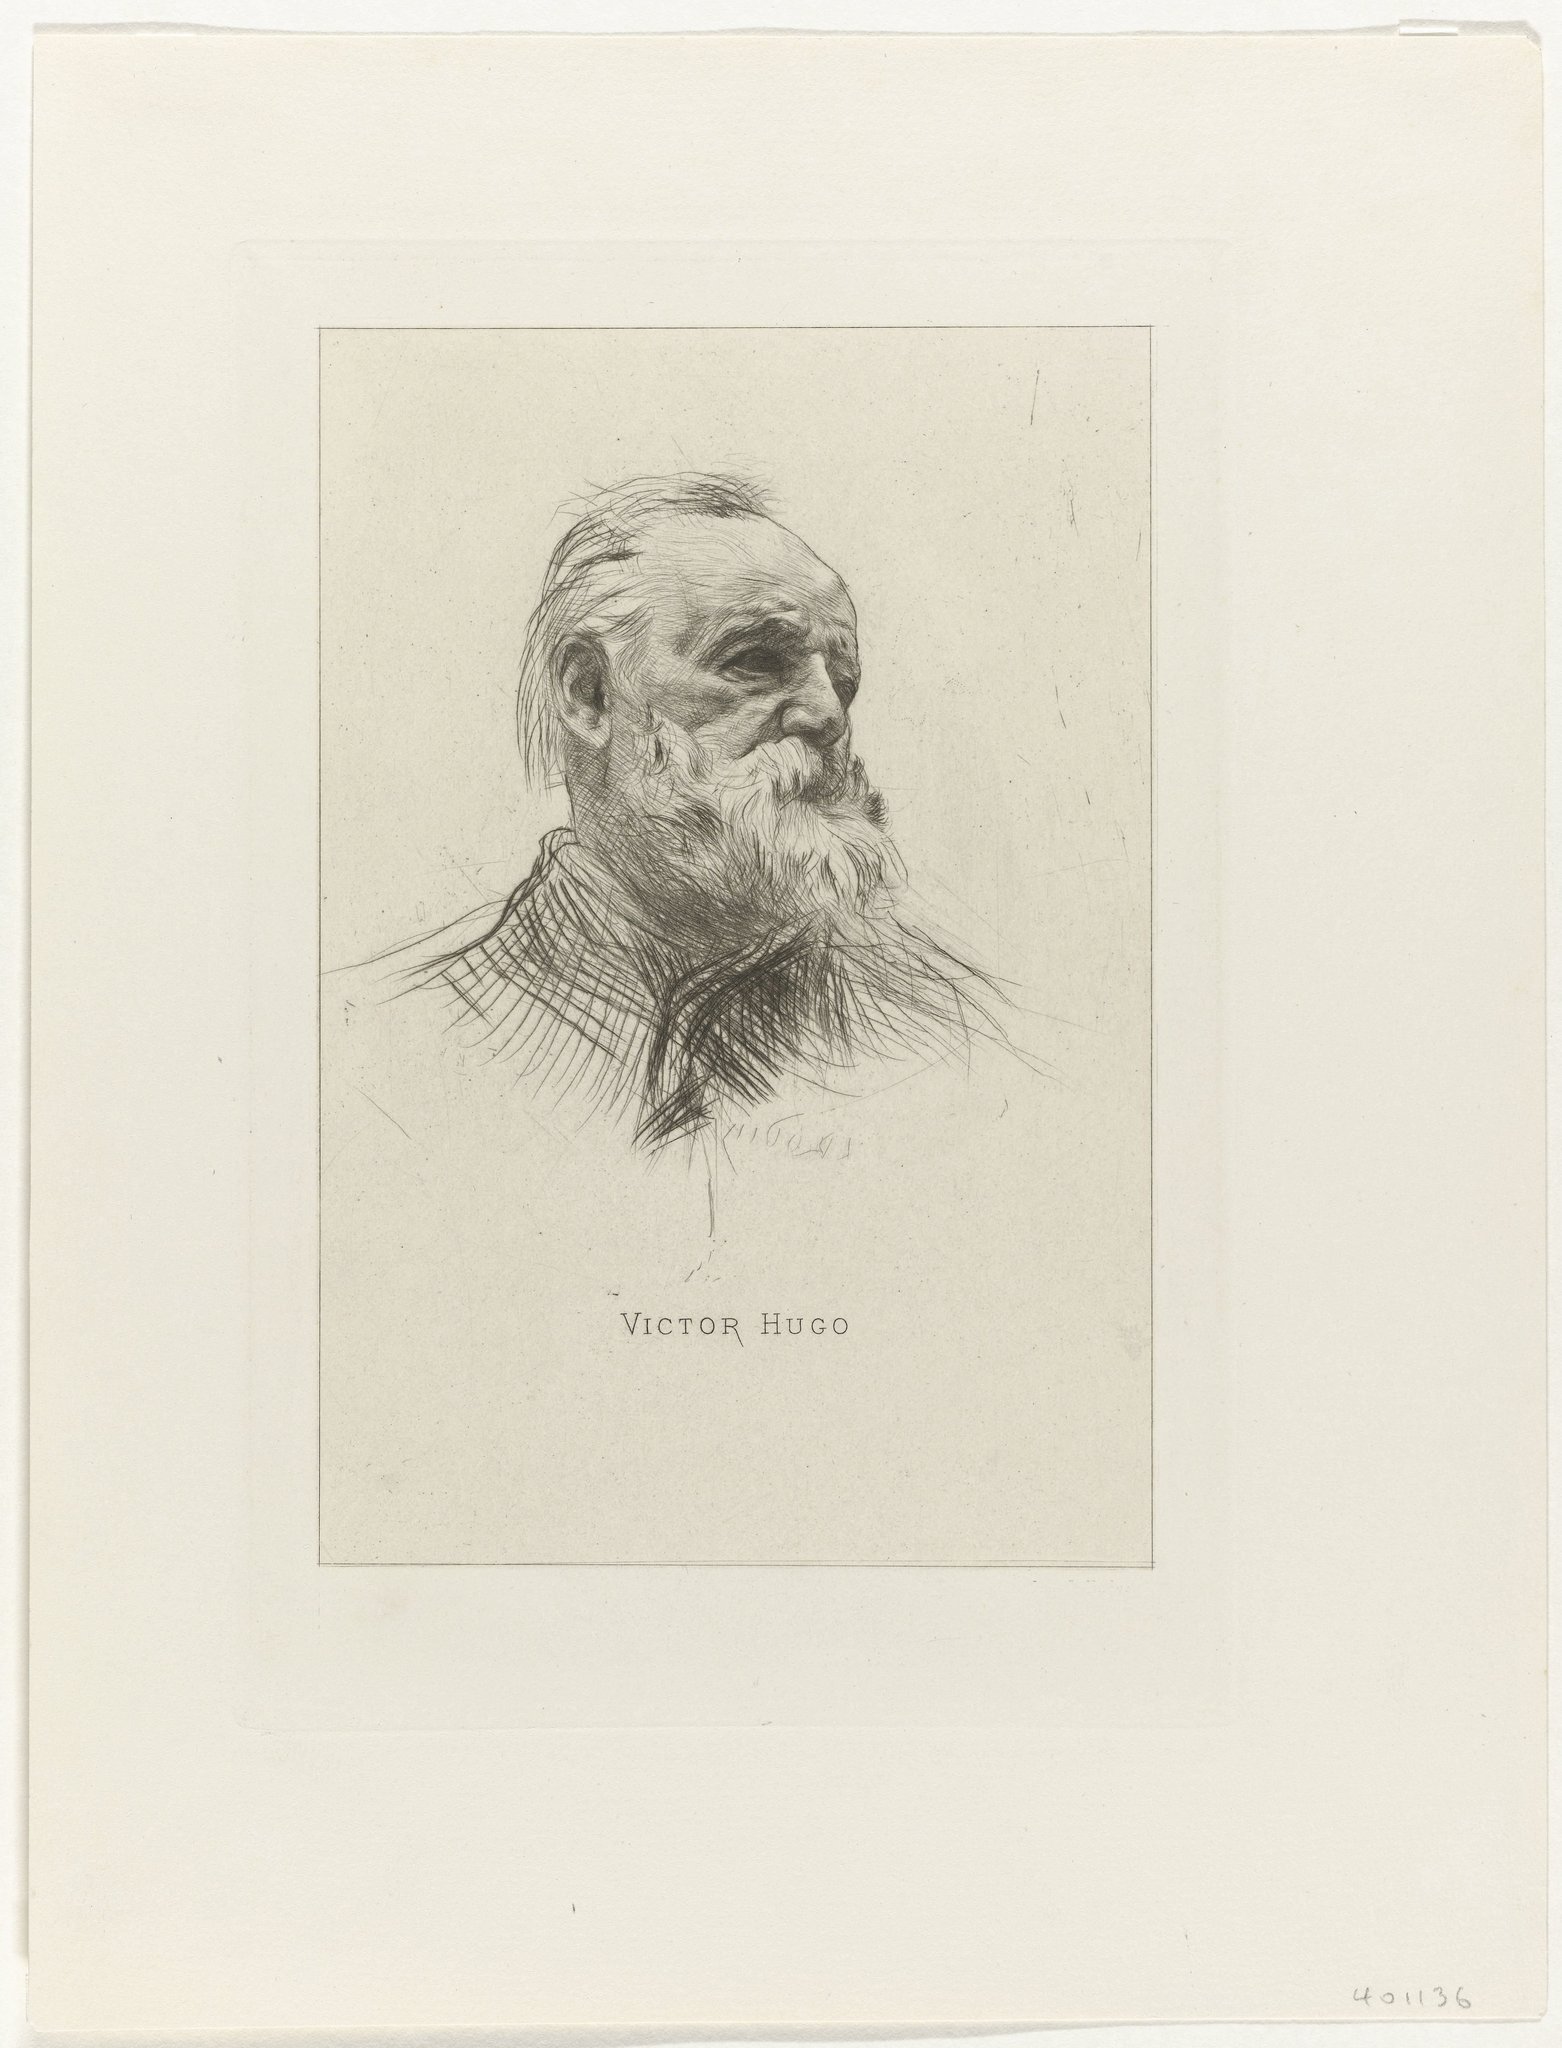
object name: print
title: Portret Victor Hugo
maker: auguste rodin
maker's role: draughtsman, print maker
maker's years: 1840-1917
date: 1884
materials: paper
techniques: drypoint, etching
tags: paris, victor hugo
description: Kop naar rechts, met baard, schuin van onderen gezien.